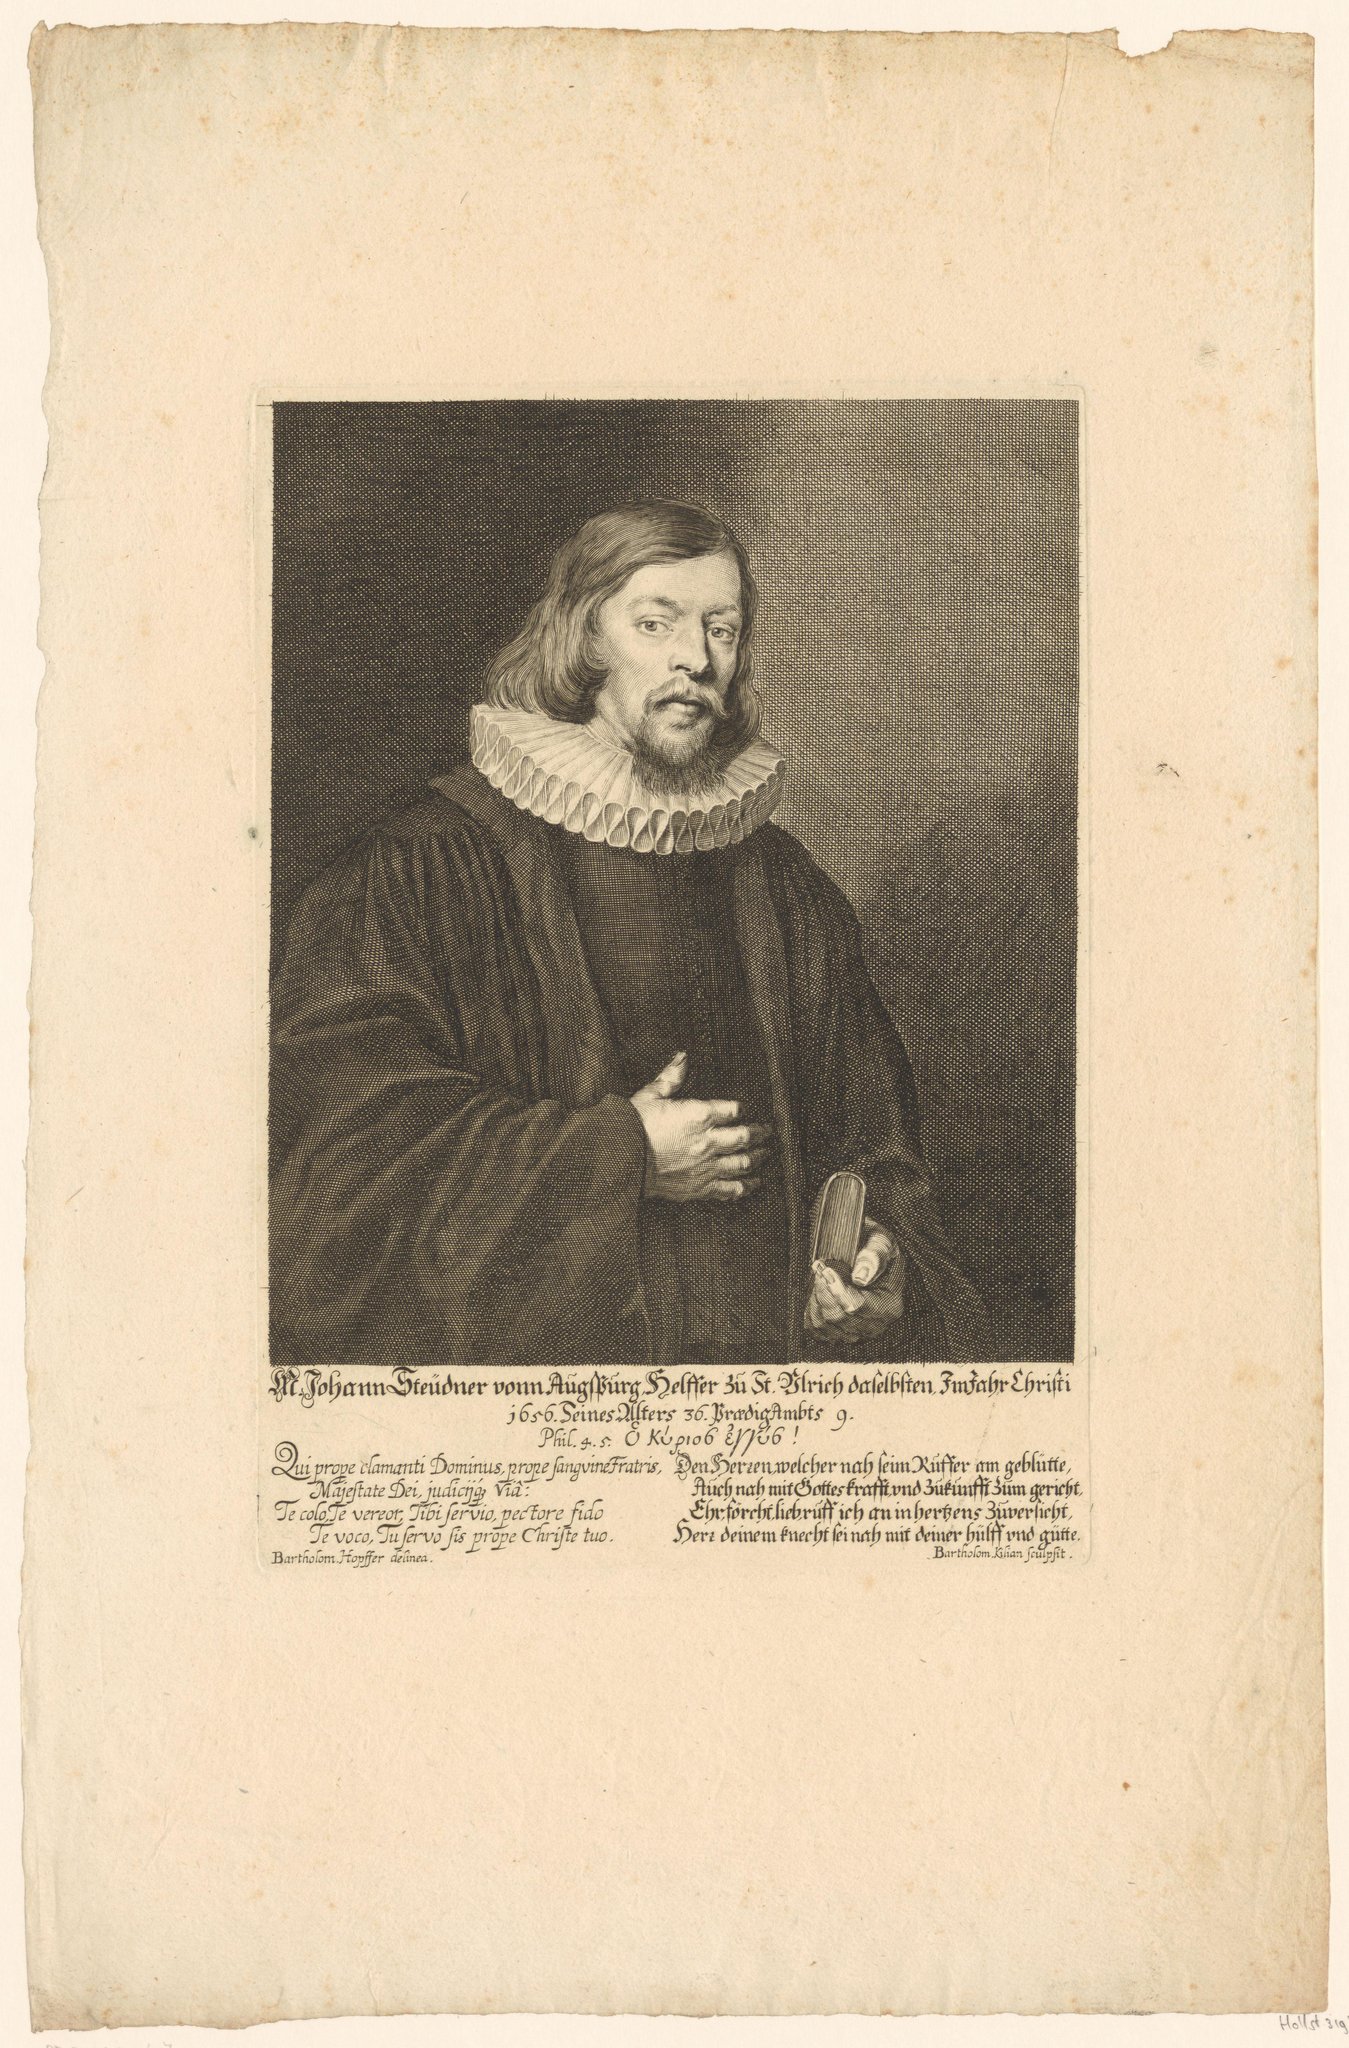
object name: print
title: Portret van Johann Steudner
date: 1656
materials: paper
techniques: engraving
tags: theologian, historical persons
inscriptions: collector's mark: Lugt 2228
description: Tekst in het Duits en Latijn in de marge.